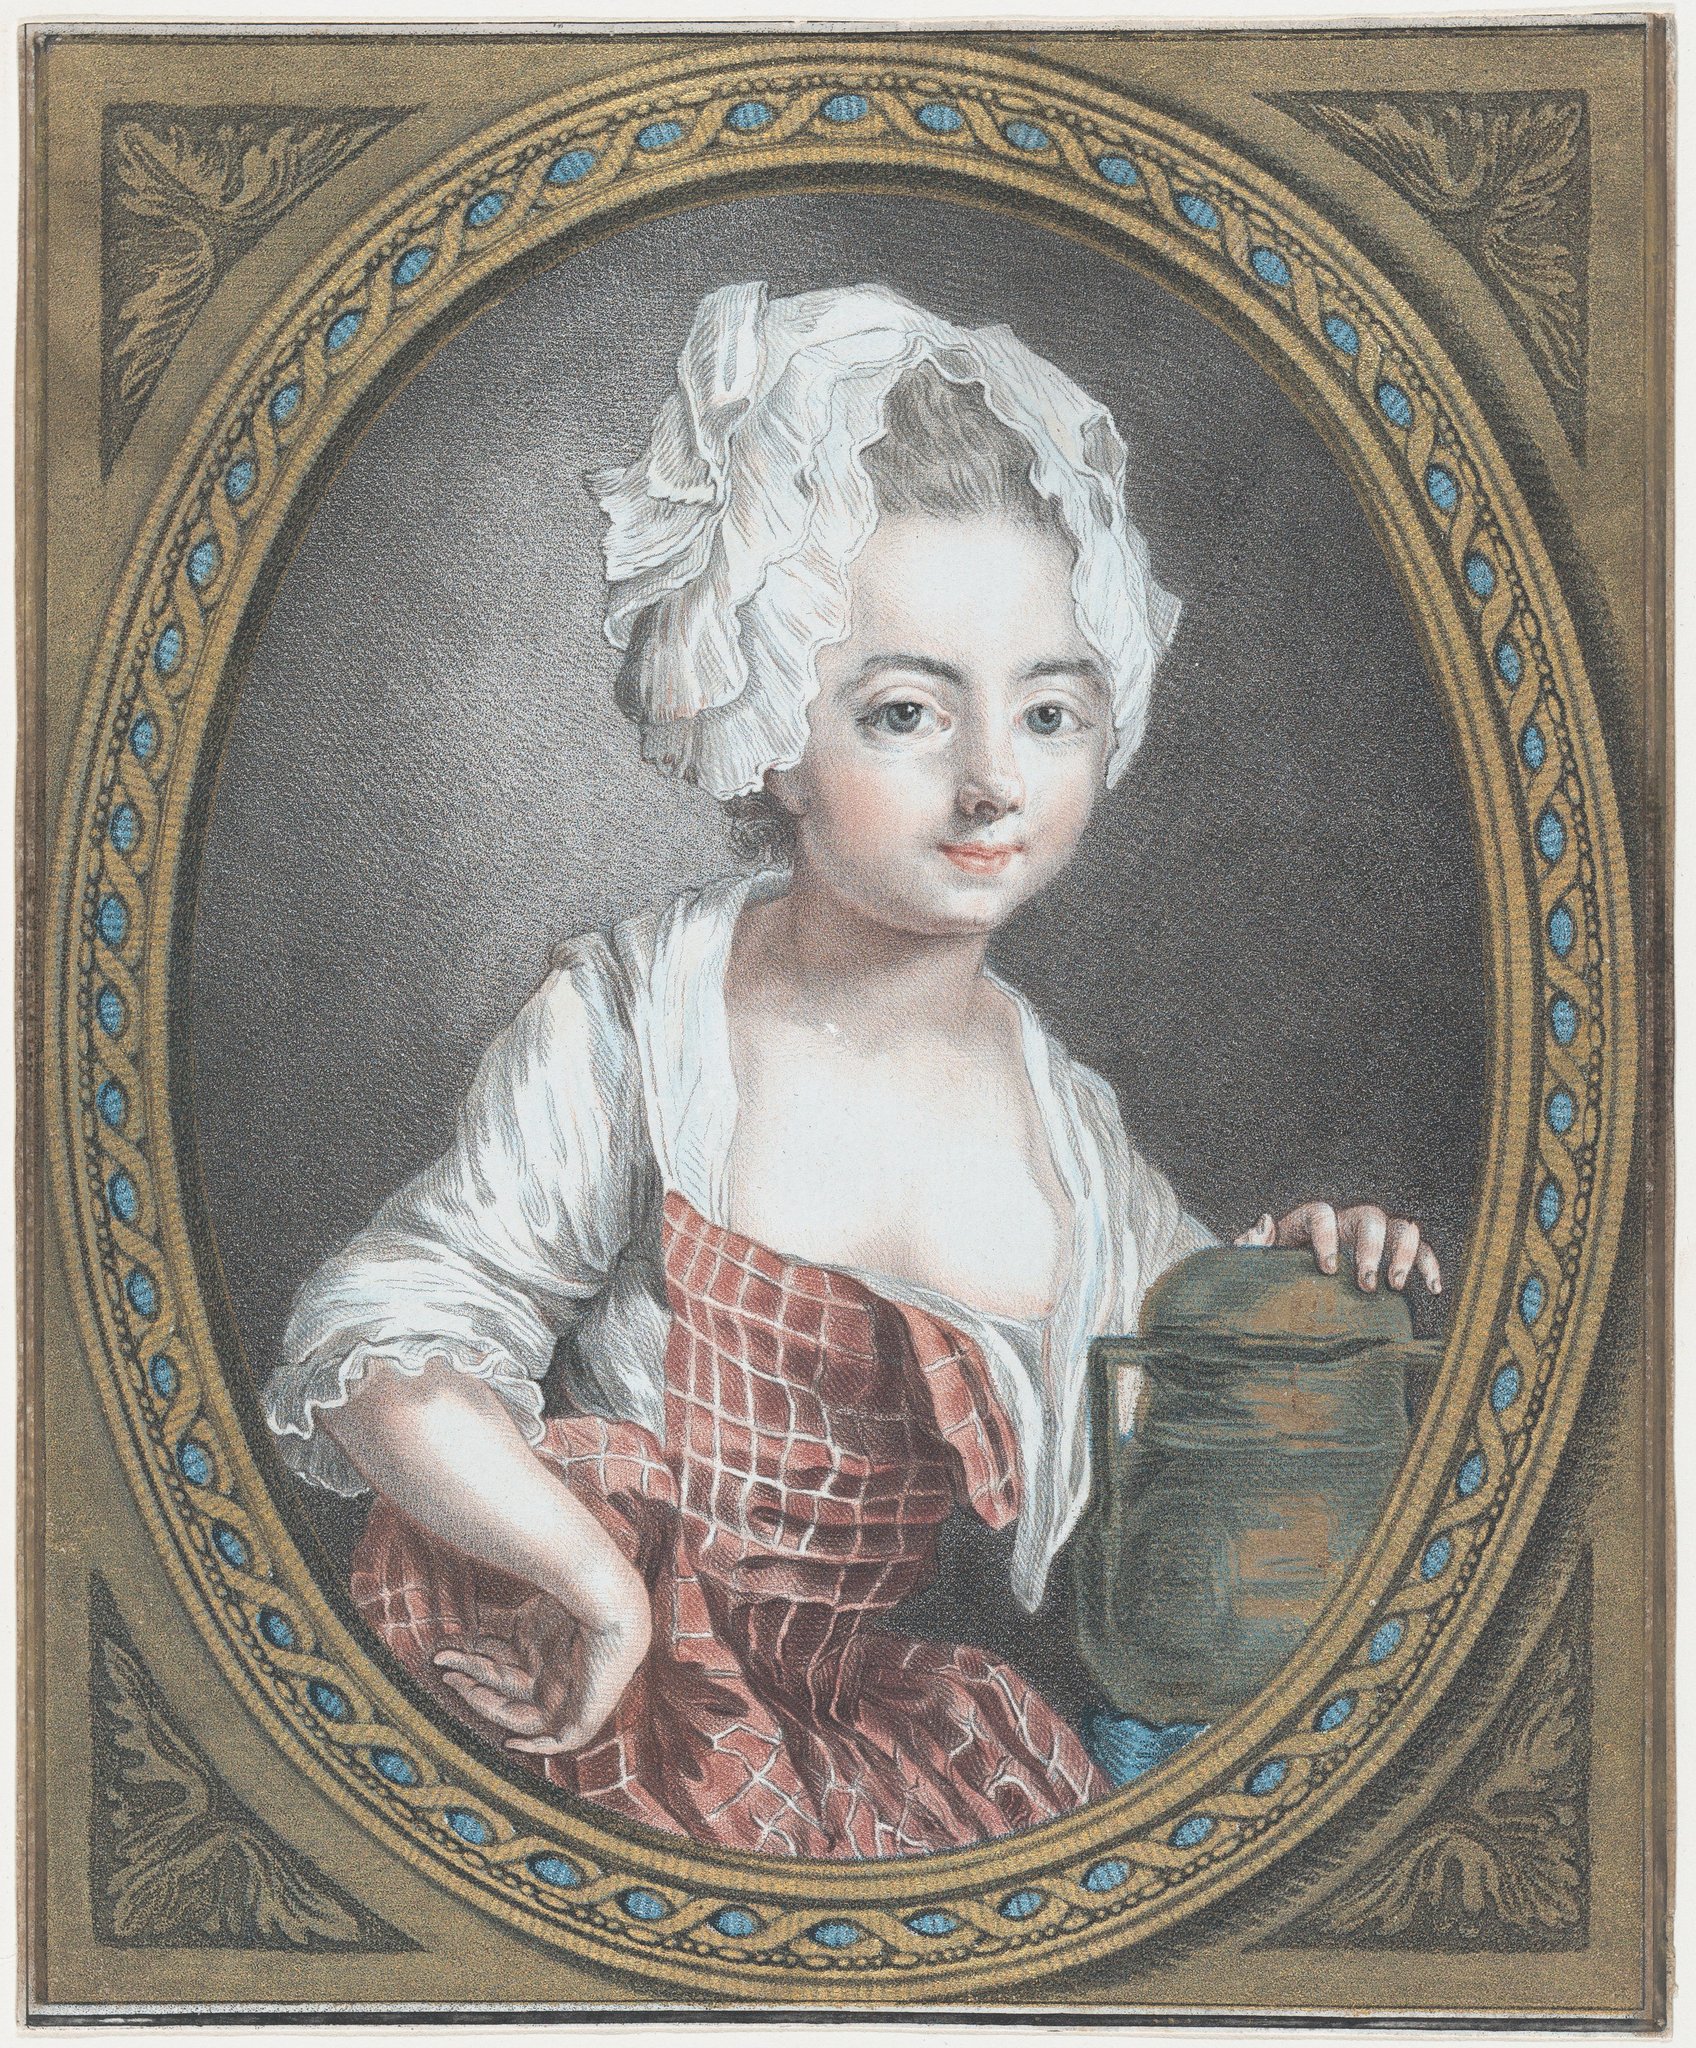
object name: print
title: The Milk Woman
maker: louis marin bonnet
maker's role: artist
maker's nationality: french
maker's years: 1736-1793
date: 1774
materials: gold leaf, ink, pastel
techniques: printing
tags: portraits,women